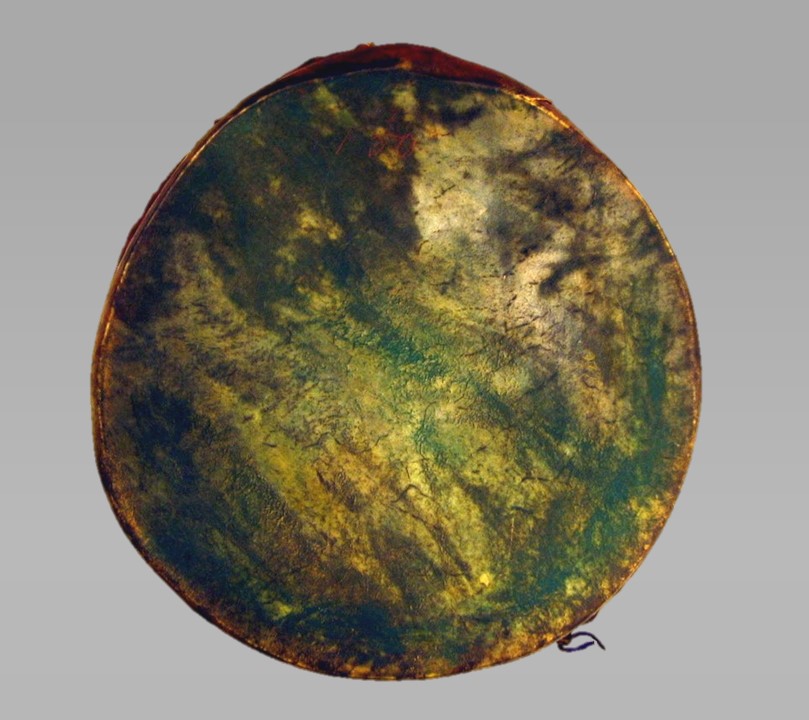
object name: frame drum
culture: native american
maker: eskimauan family?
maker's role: maker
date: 1801-1900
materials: iron, skin, wood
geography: united states